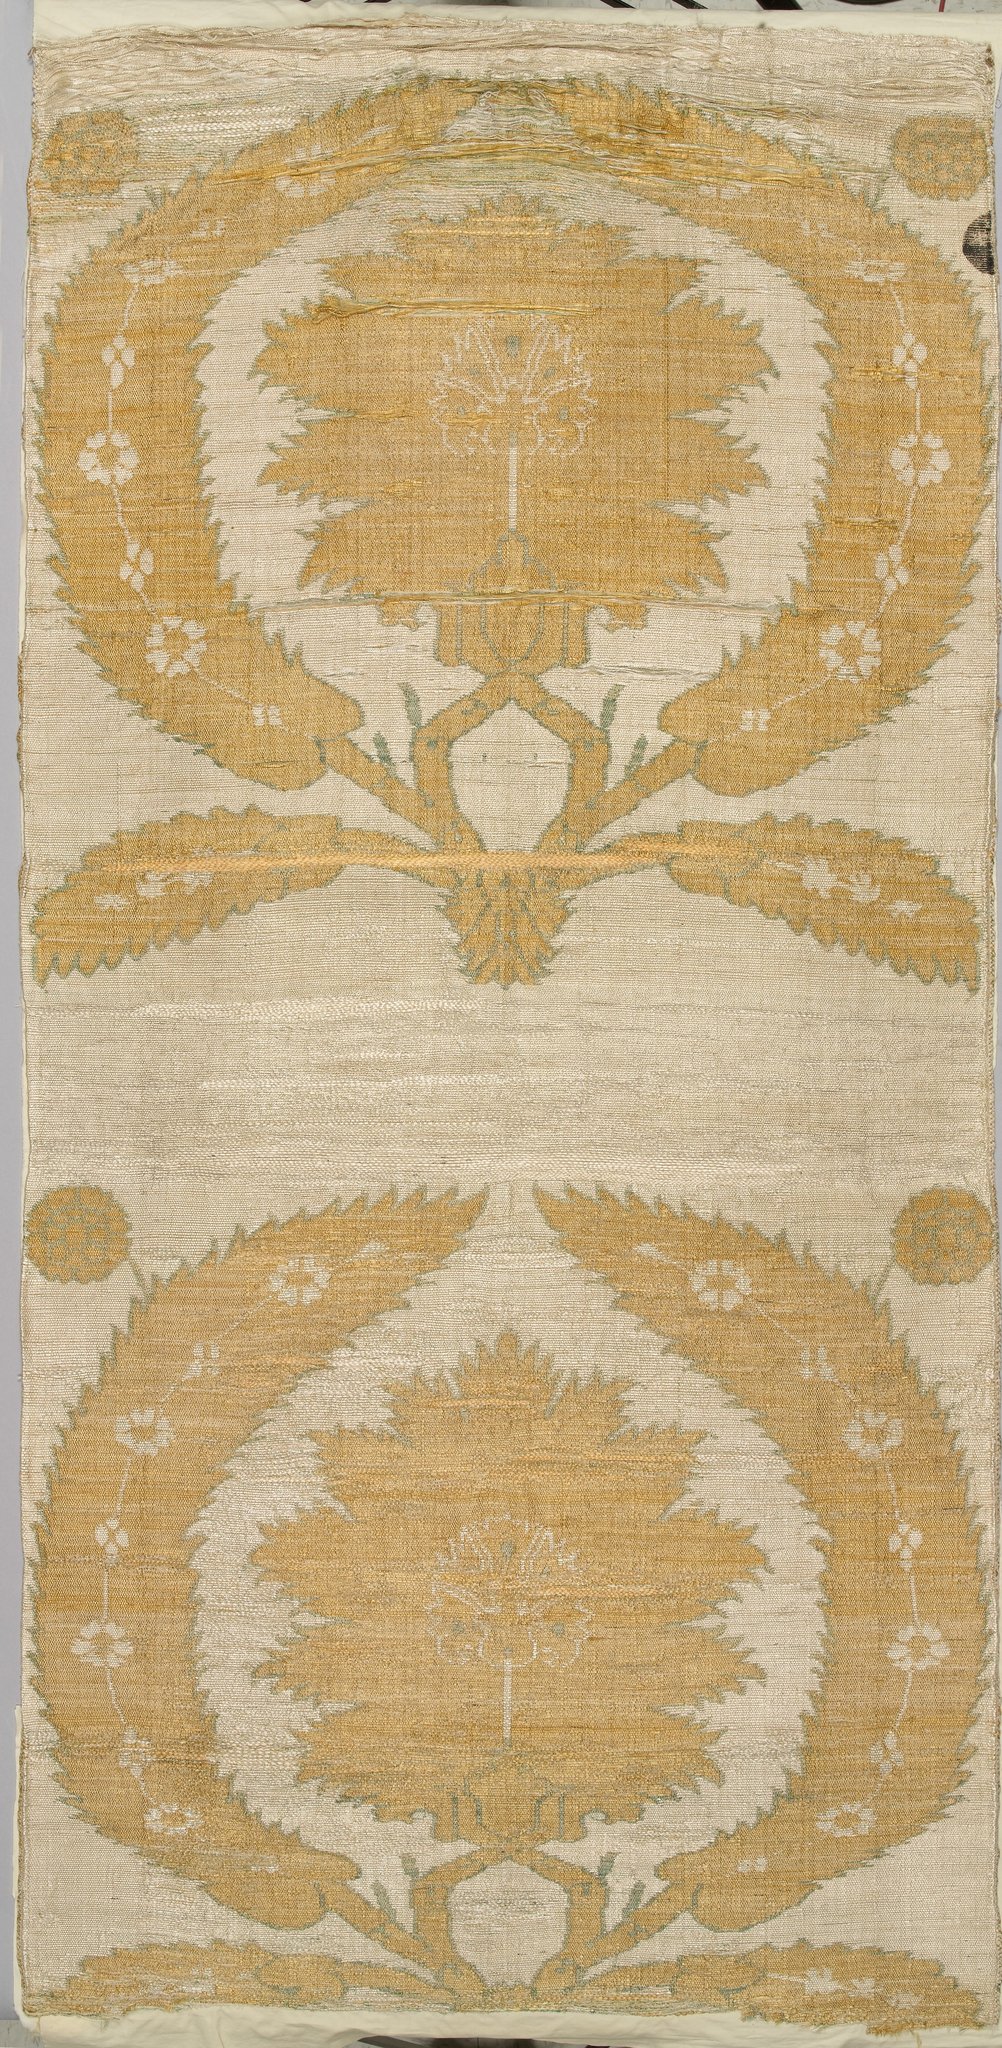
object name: fragment of a robe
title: Kaftan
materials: metal thread, silk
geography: turkey